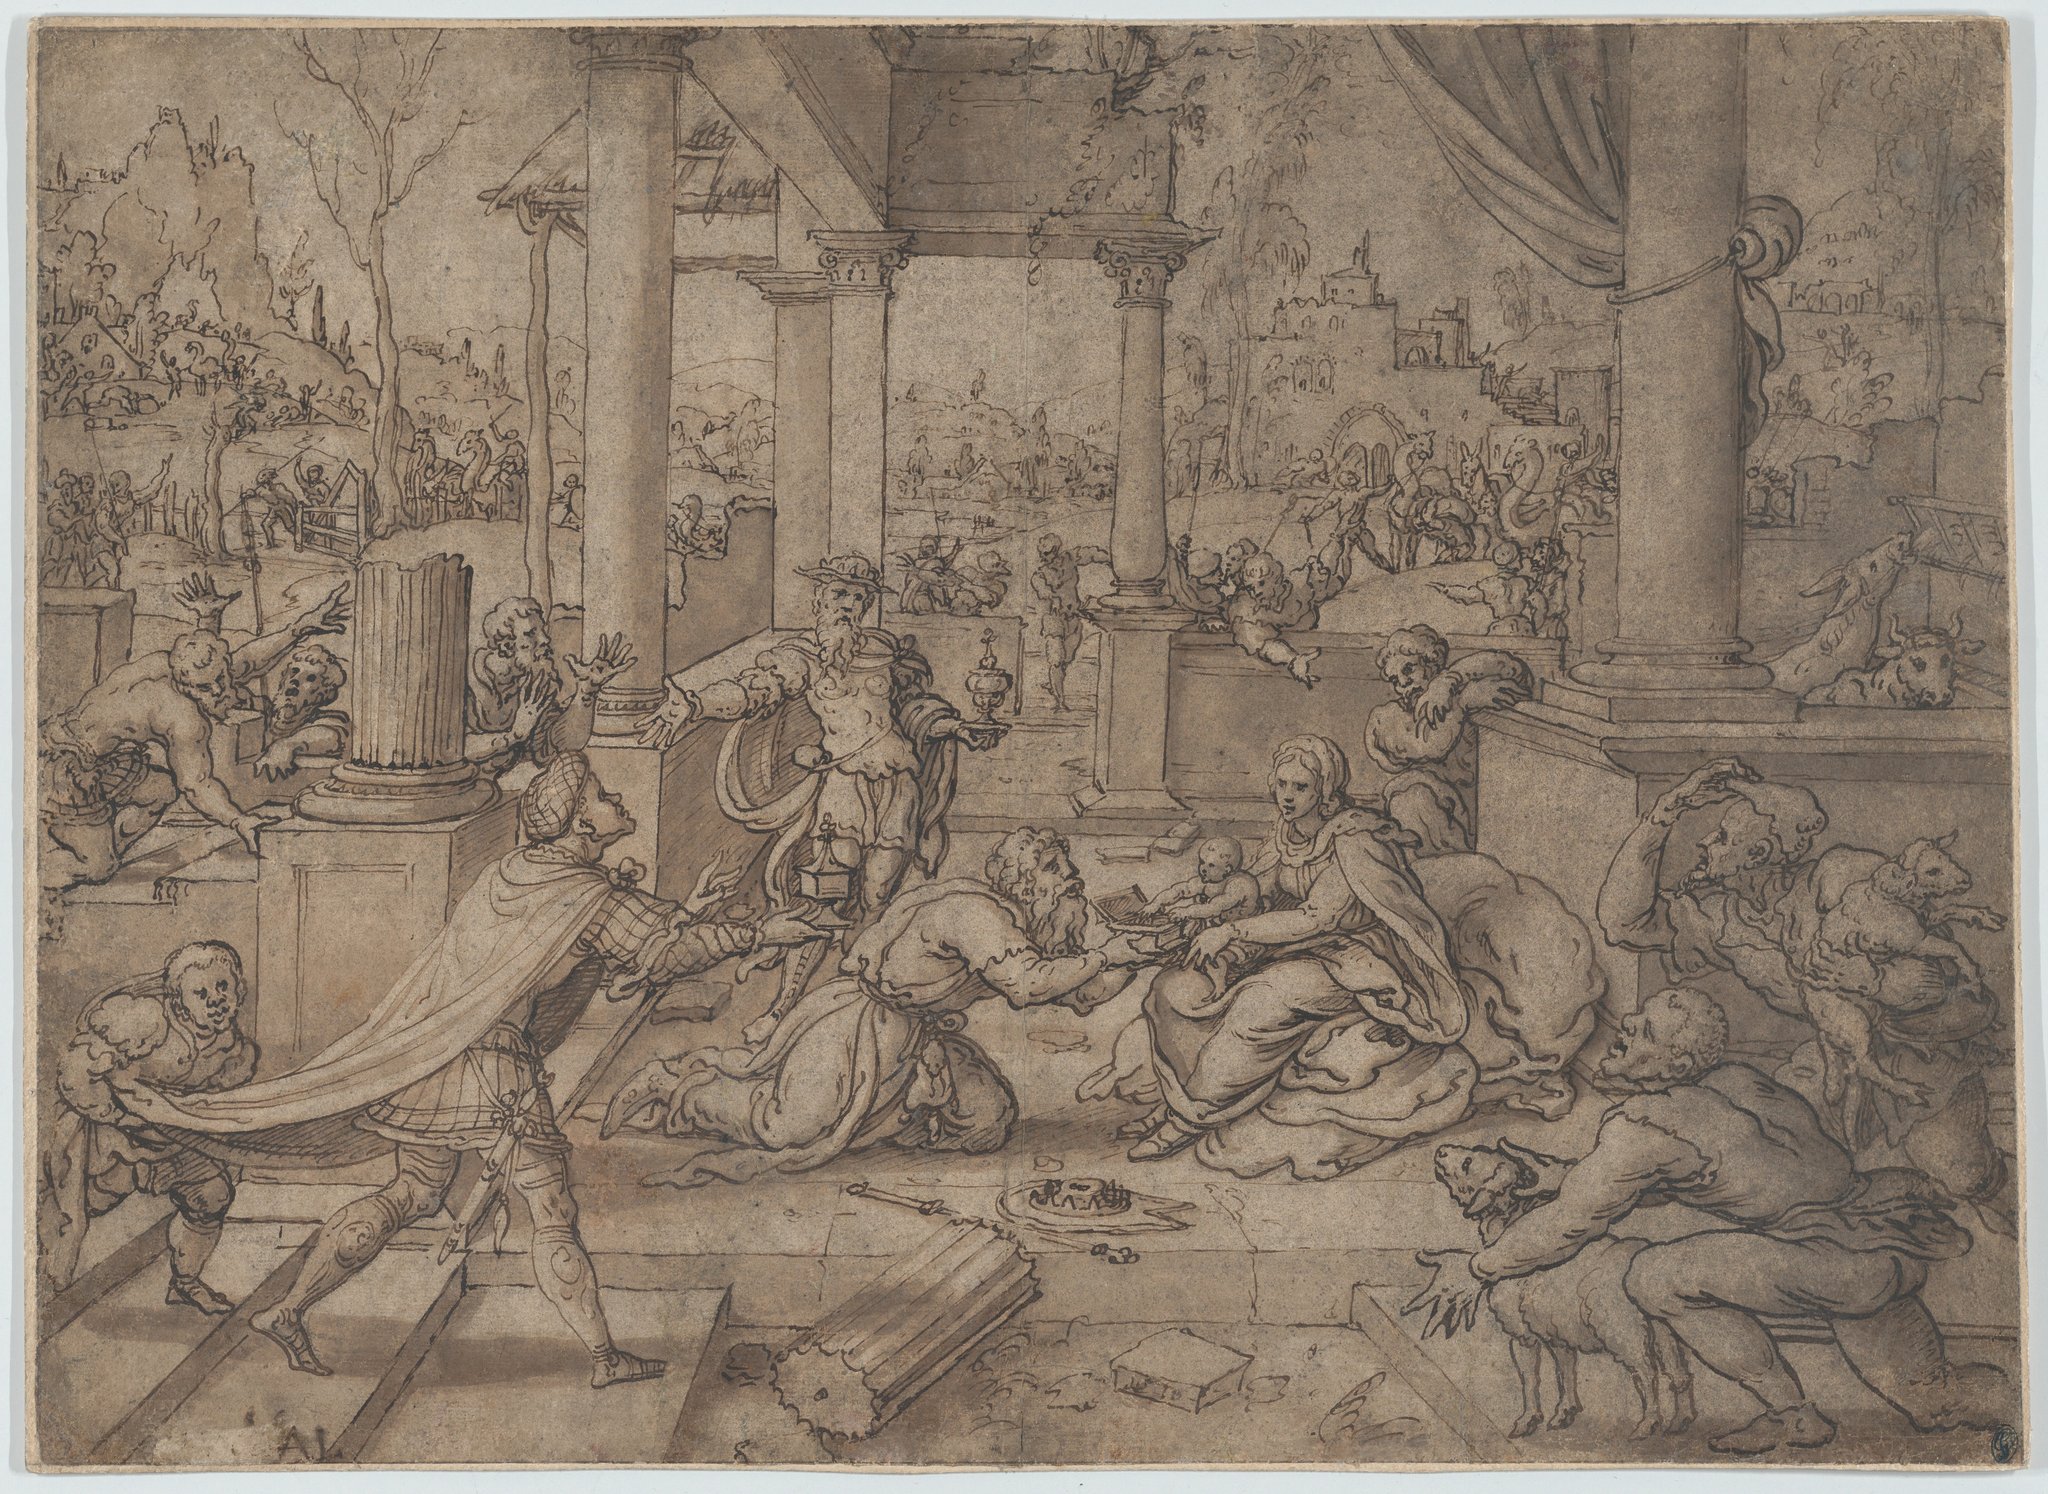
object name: drawing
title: The Adoration of the Magi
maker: bernard van orley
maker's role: artist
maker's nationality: netherlandish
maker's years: 1492-1542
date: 1501-1566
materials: chalk, ink, paper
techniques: pen, wash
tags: men,virgin mary,jesus,adoration of the magi